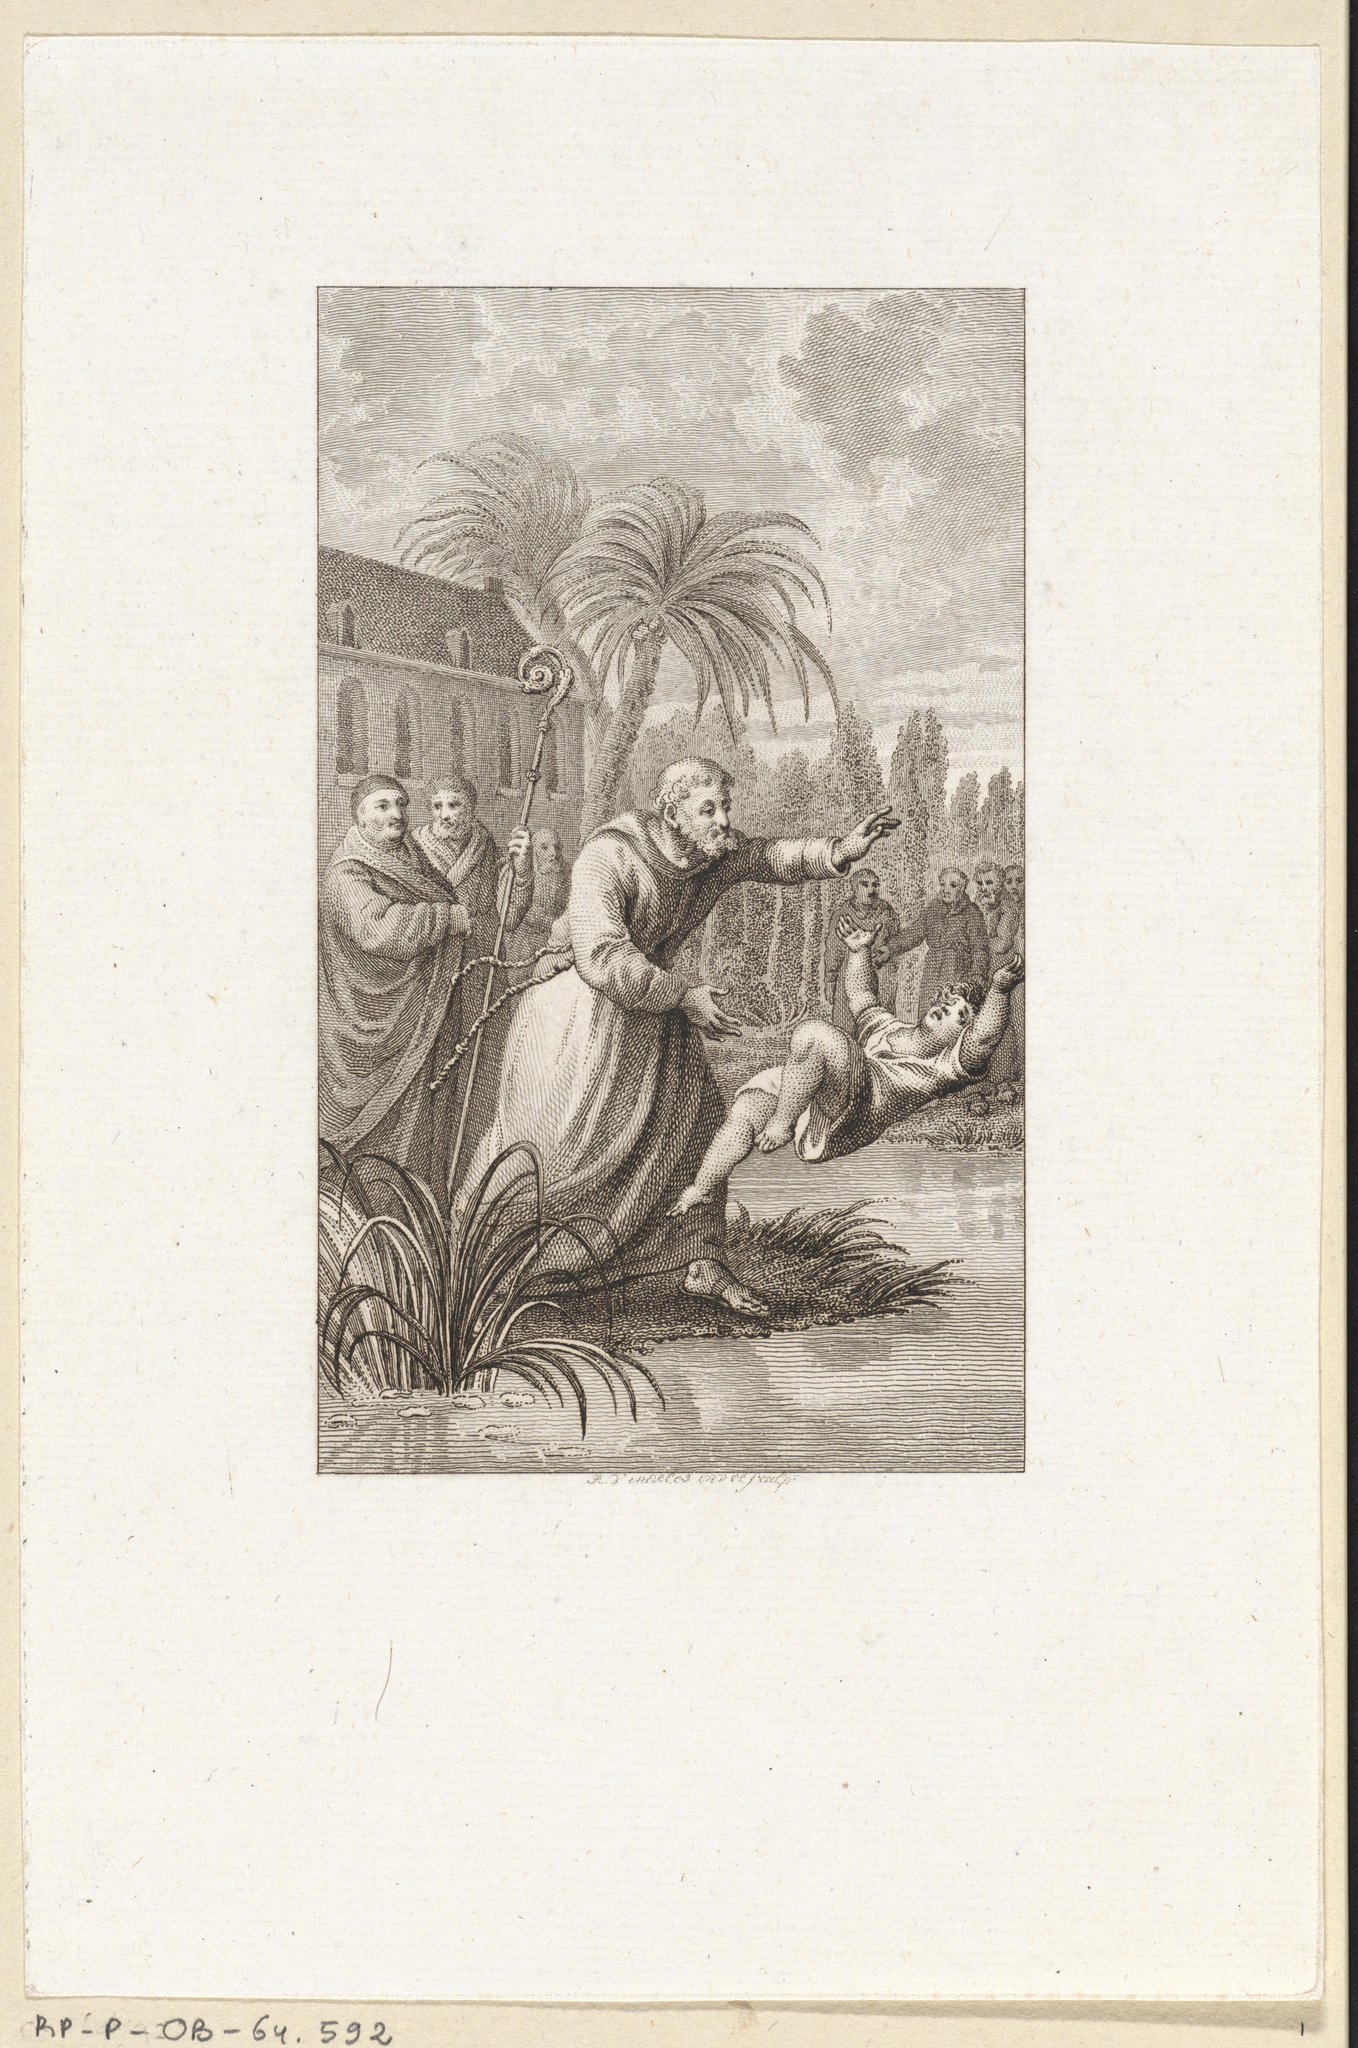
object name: print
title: Mucius gooit zijn zoon in een rivier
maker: reinier vinkeles (i)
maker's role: draughtsman, print maker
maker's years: 1741-1816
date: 1803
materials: paper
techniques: engraving, etching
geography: amsterdam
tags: river, monk(s), friar(s), father and son(s) (family group)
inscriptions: collector's mark: Lugt 240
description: Proefdruk voor illustratie in: Hamelsveld, Ysbrand van. Algemeene kerkelijke geschiedenis, der Christenen, deel 6. Haarlem: François Bohn, 1803, p. 77.